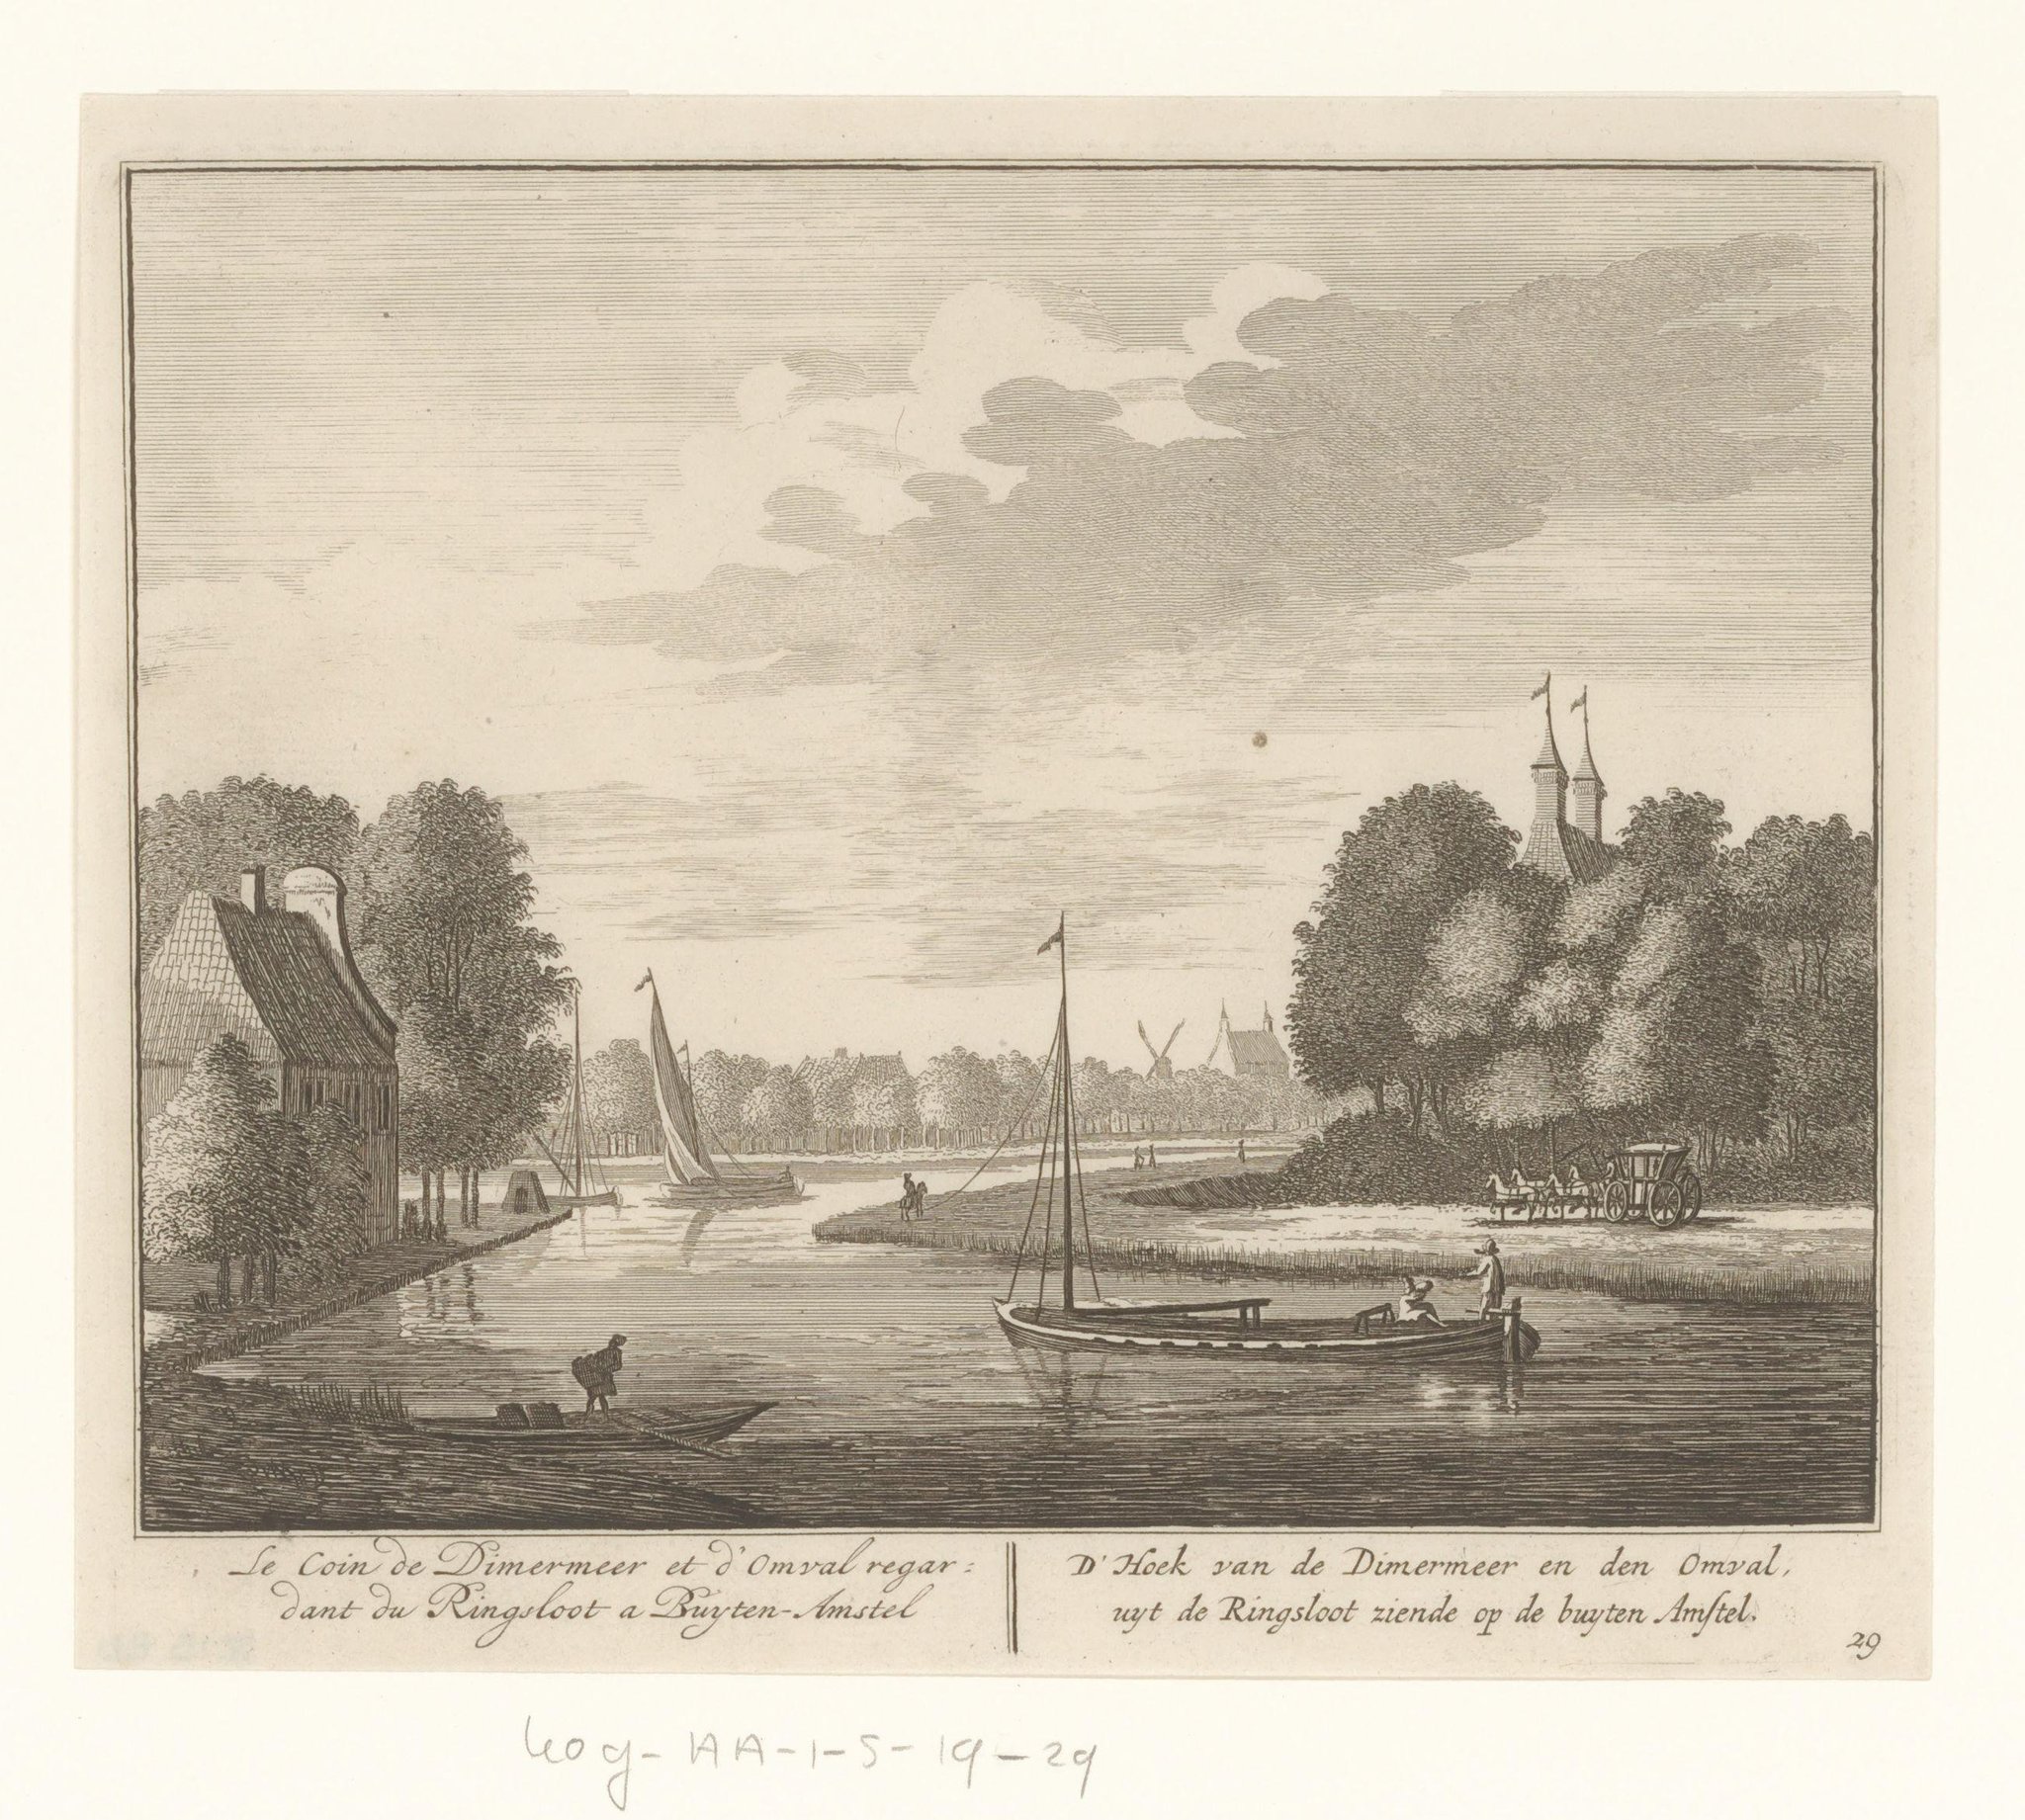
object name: print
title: Hollands Arcadia, of de vermaarde rivier den Amstel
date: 1730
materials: paper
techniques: etching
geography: amsterdam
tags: sailing-ship, sailing-boat, city-view in general; 'veduta', river, boat propelled by man or animal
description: Prent waarschijnlijk uit: Tijsens, Gijsbert. Hollands Arcadia, of de vermaarde rivier den Amstel (...) naar 't léven getekend en in 't ligt gebragt door Abraham Rademaker (...). Amsterdam: Leonardus Schenk, 1730.